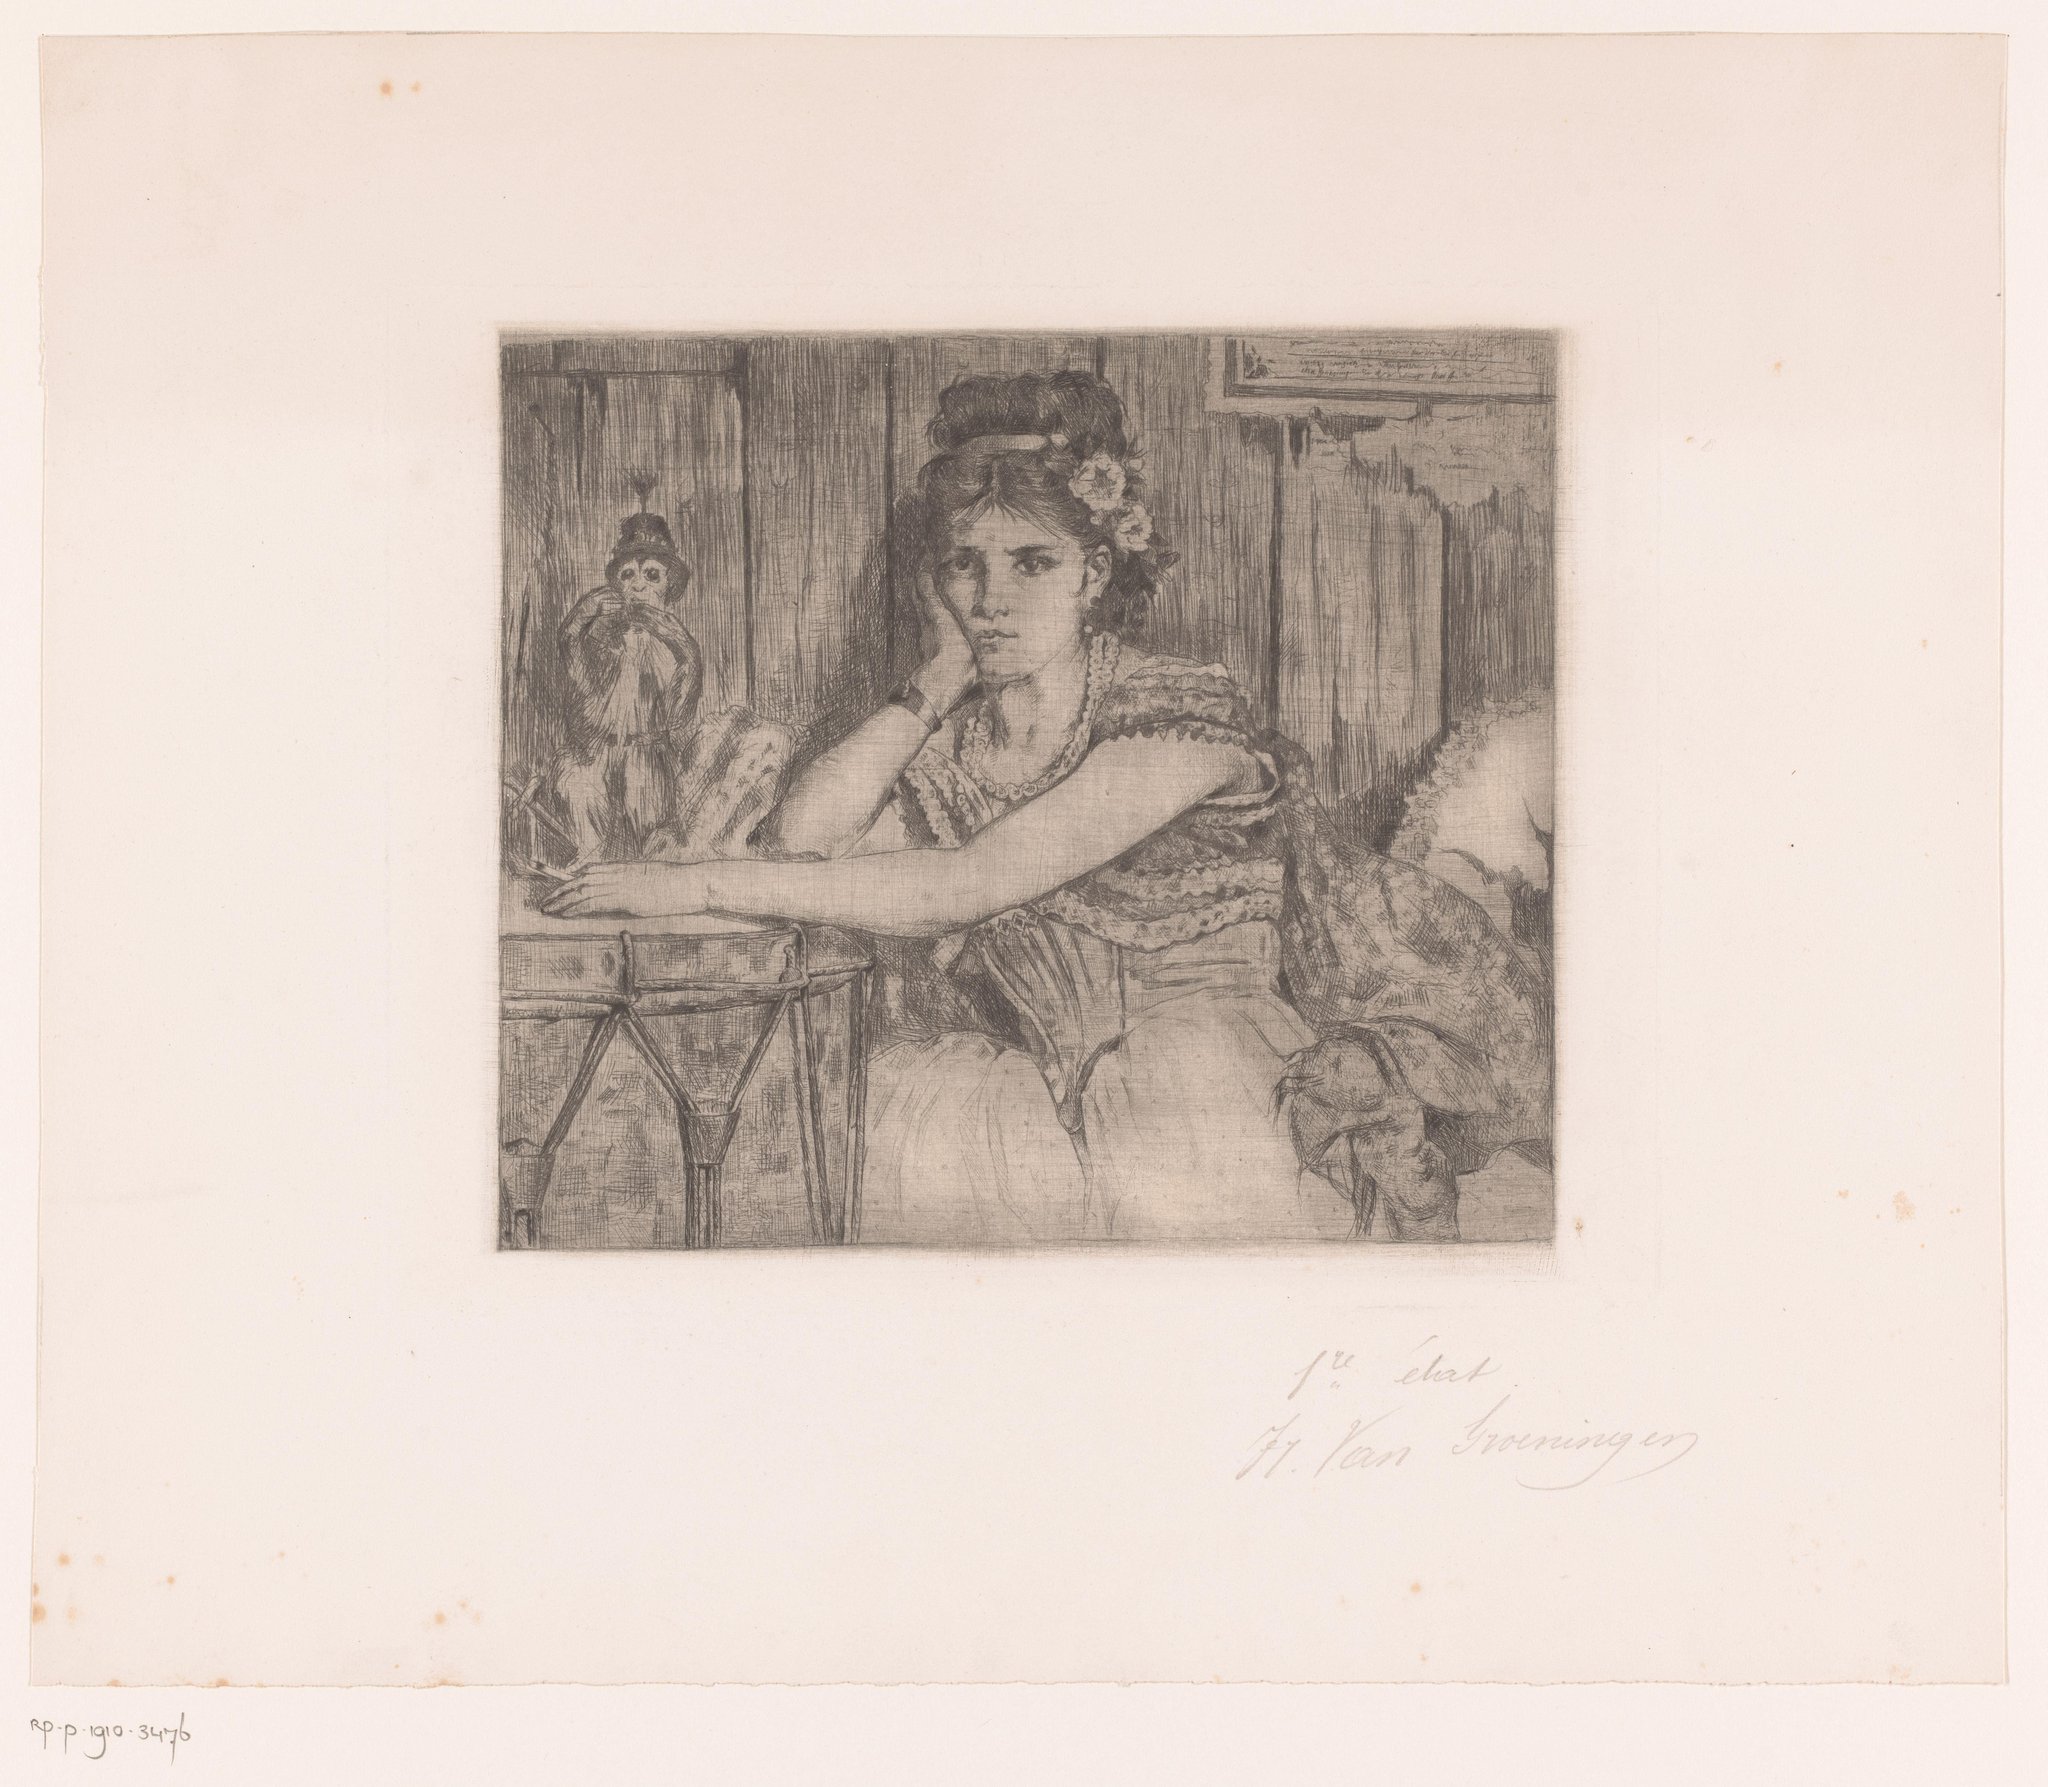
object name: print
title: Zittende jonge vrouw met een circusaap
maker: fr. van groeningen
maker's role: print maker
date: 1884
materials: paper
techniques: etching, intaglio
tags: adolescent, young woman, maiden, monkeys (circus performance)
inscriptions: annotation: ‘1re état’, collector's mark: Lugt 2228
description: Sterfdatum prentmaker onbekend. Derhalve is voor bepaling van de rechten van dit object de verwervingsdatum aangehouden.